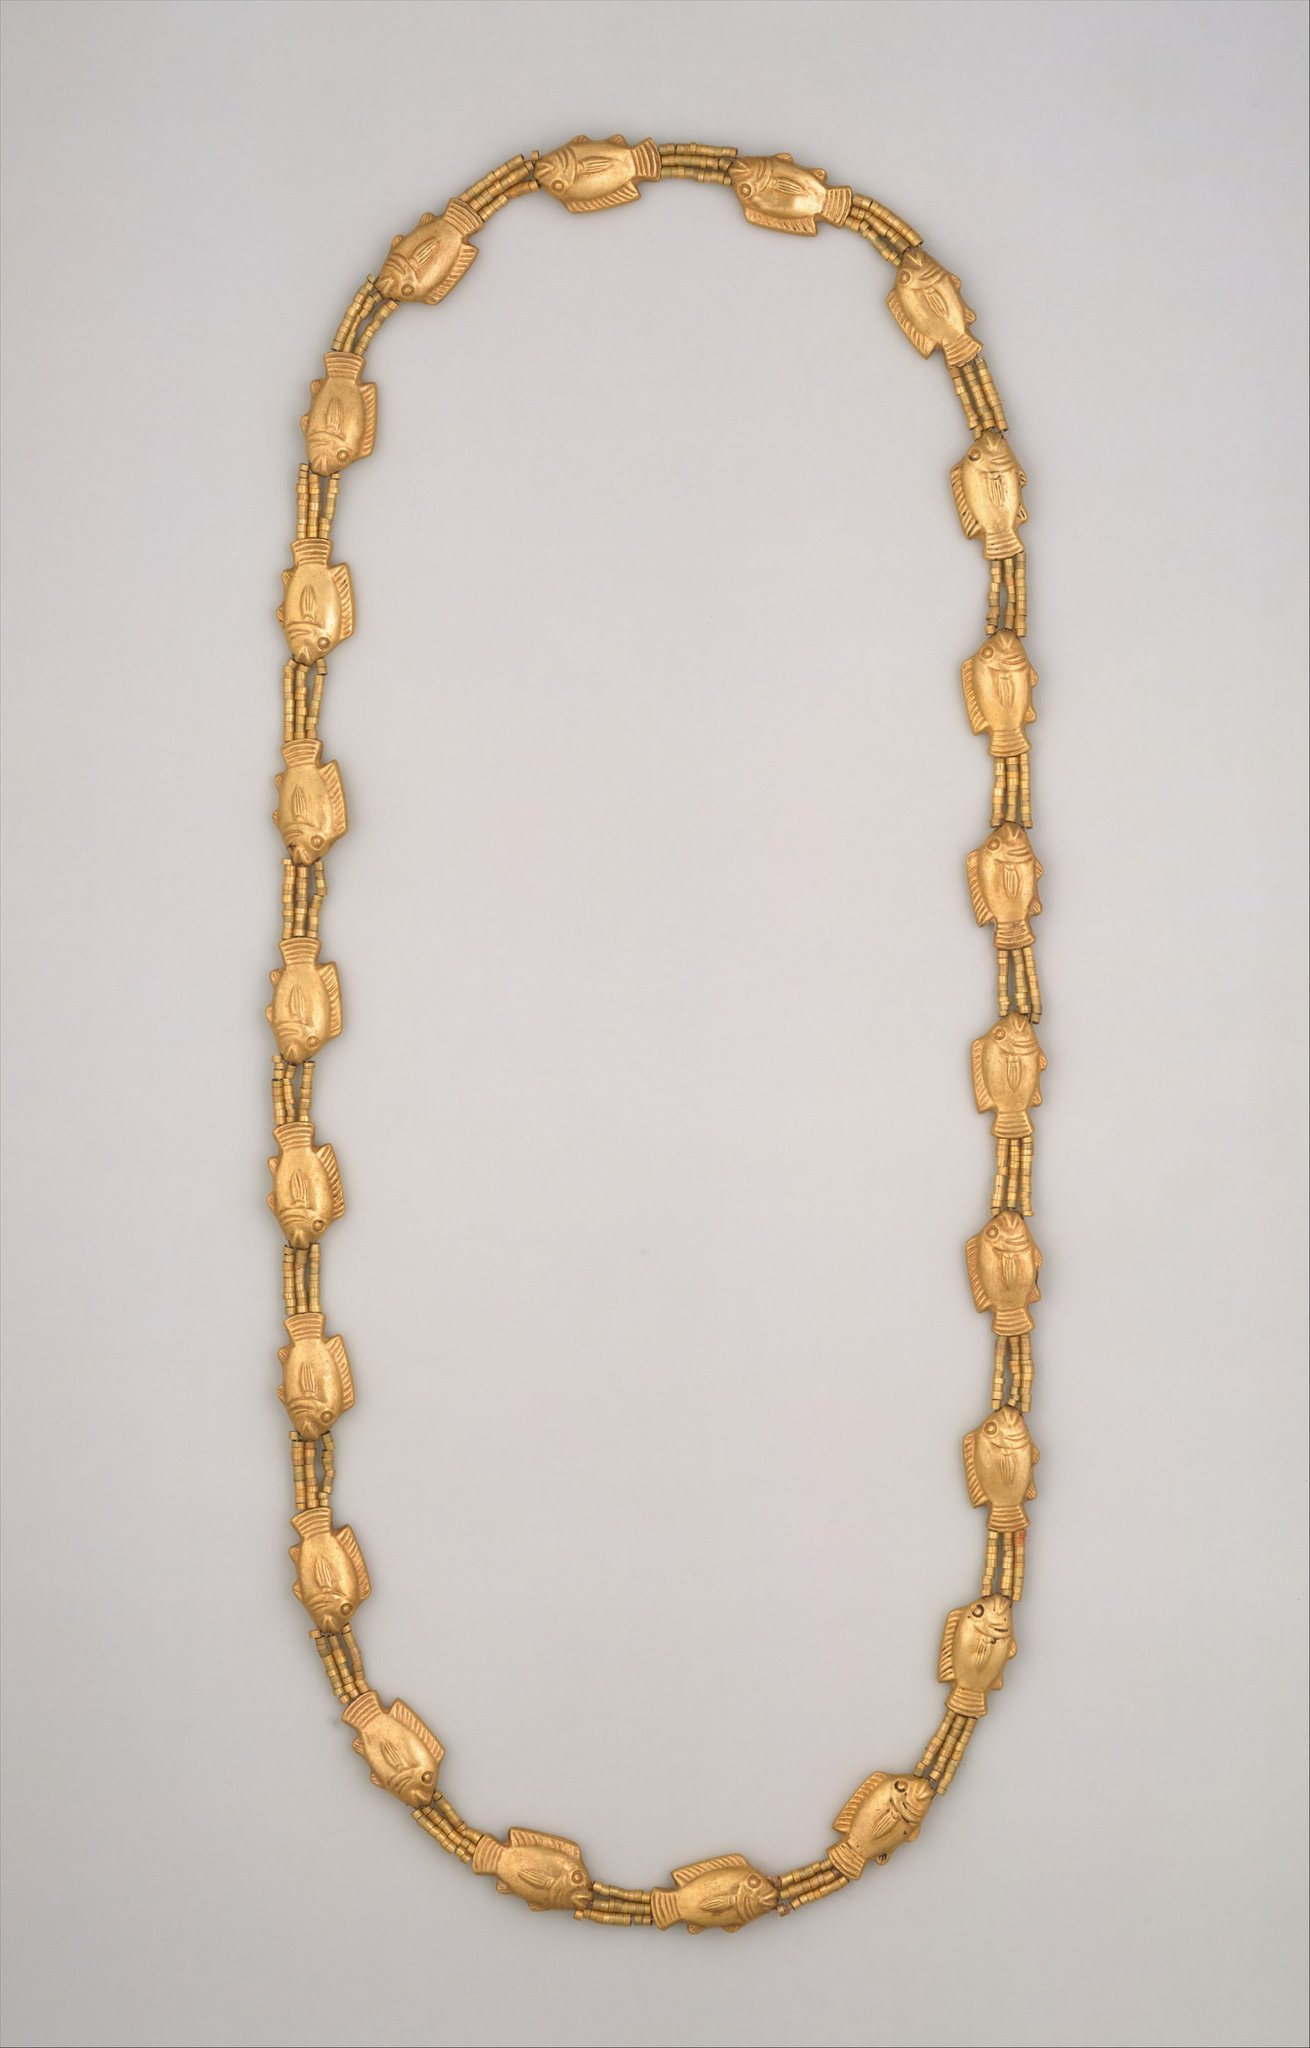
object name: girdle, fish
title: Girdle with Fish-Shaped Beads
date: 1479-1425 BCE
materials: gold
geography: egypt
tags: fish